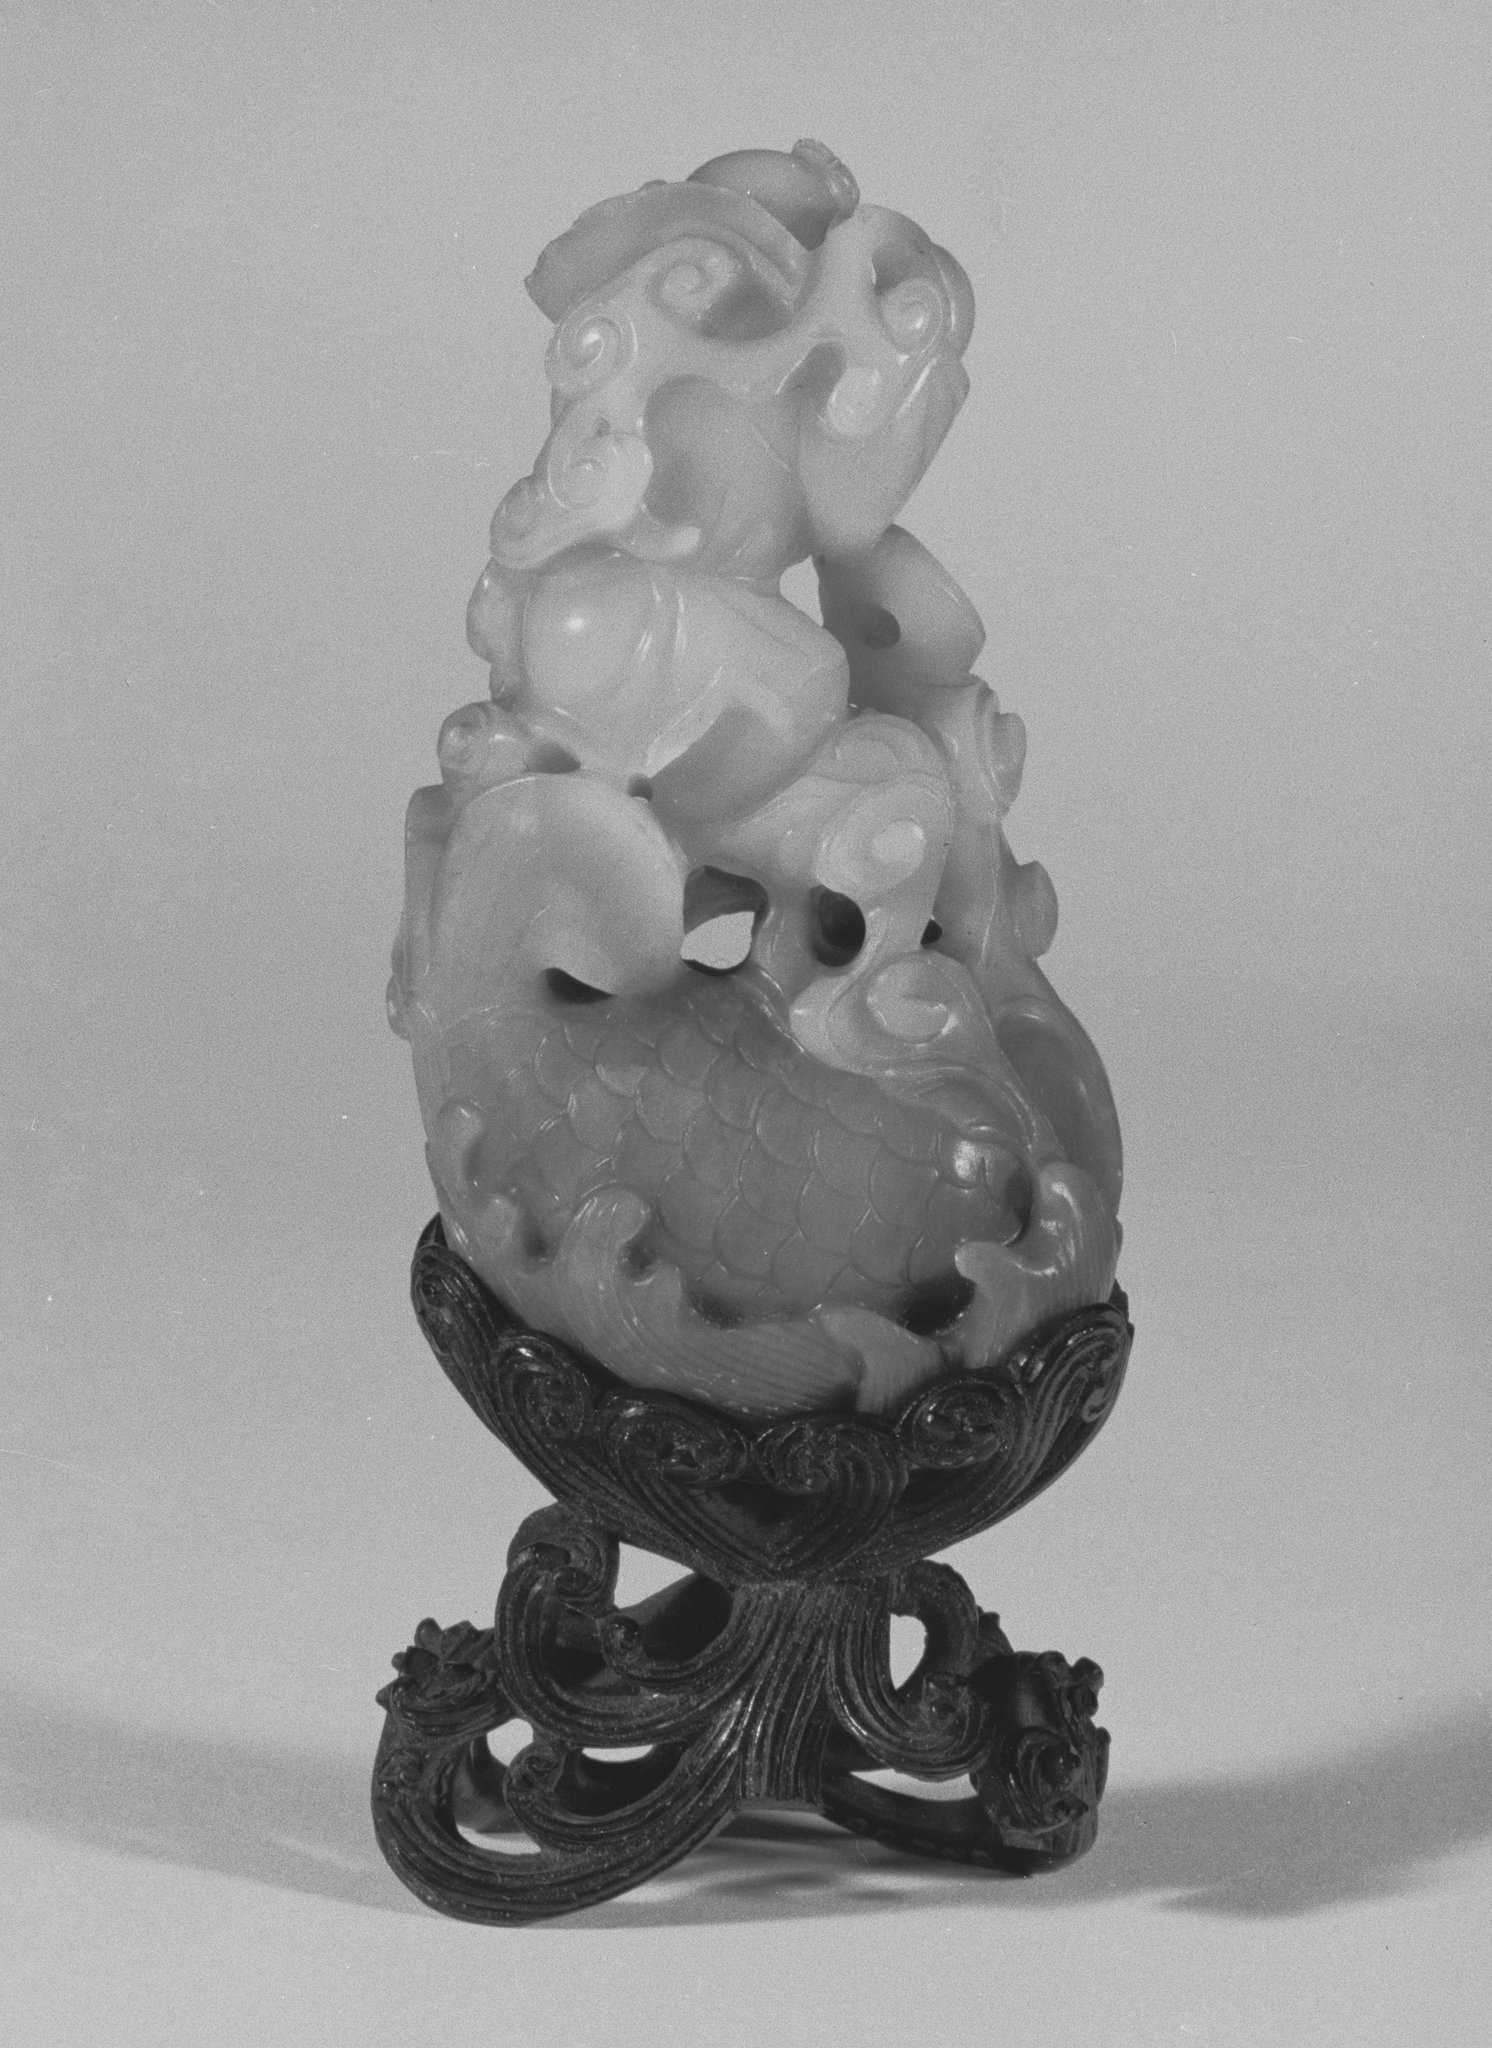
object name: statuette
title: Boy Standing on Fish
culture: chinese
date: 1701-1800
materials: jade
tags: fish